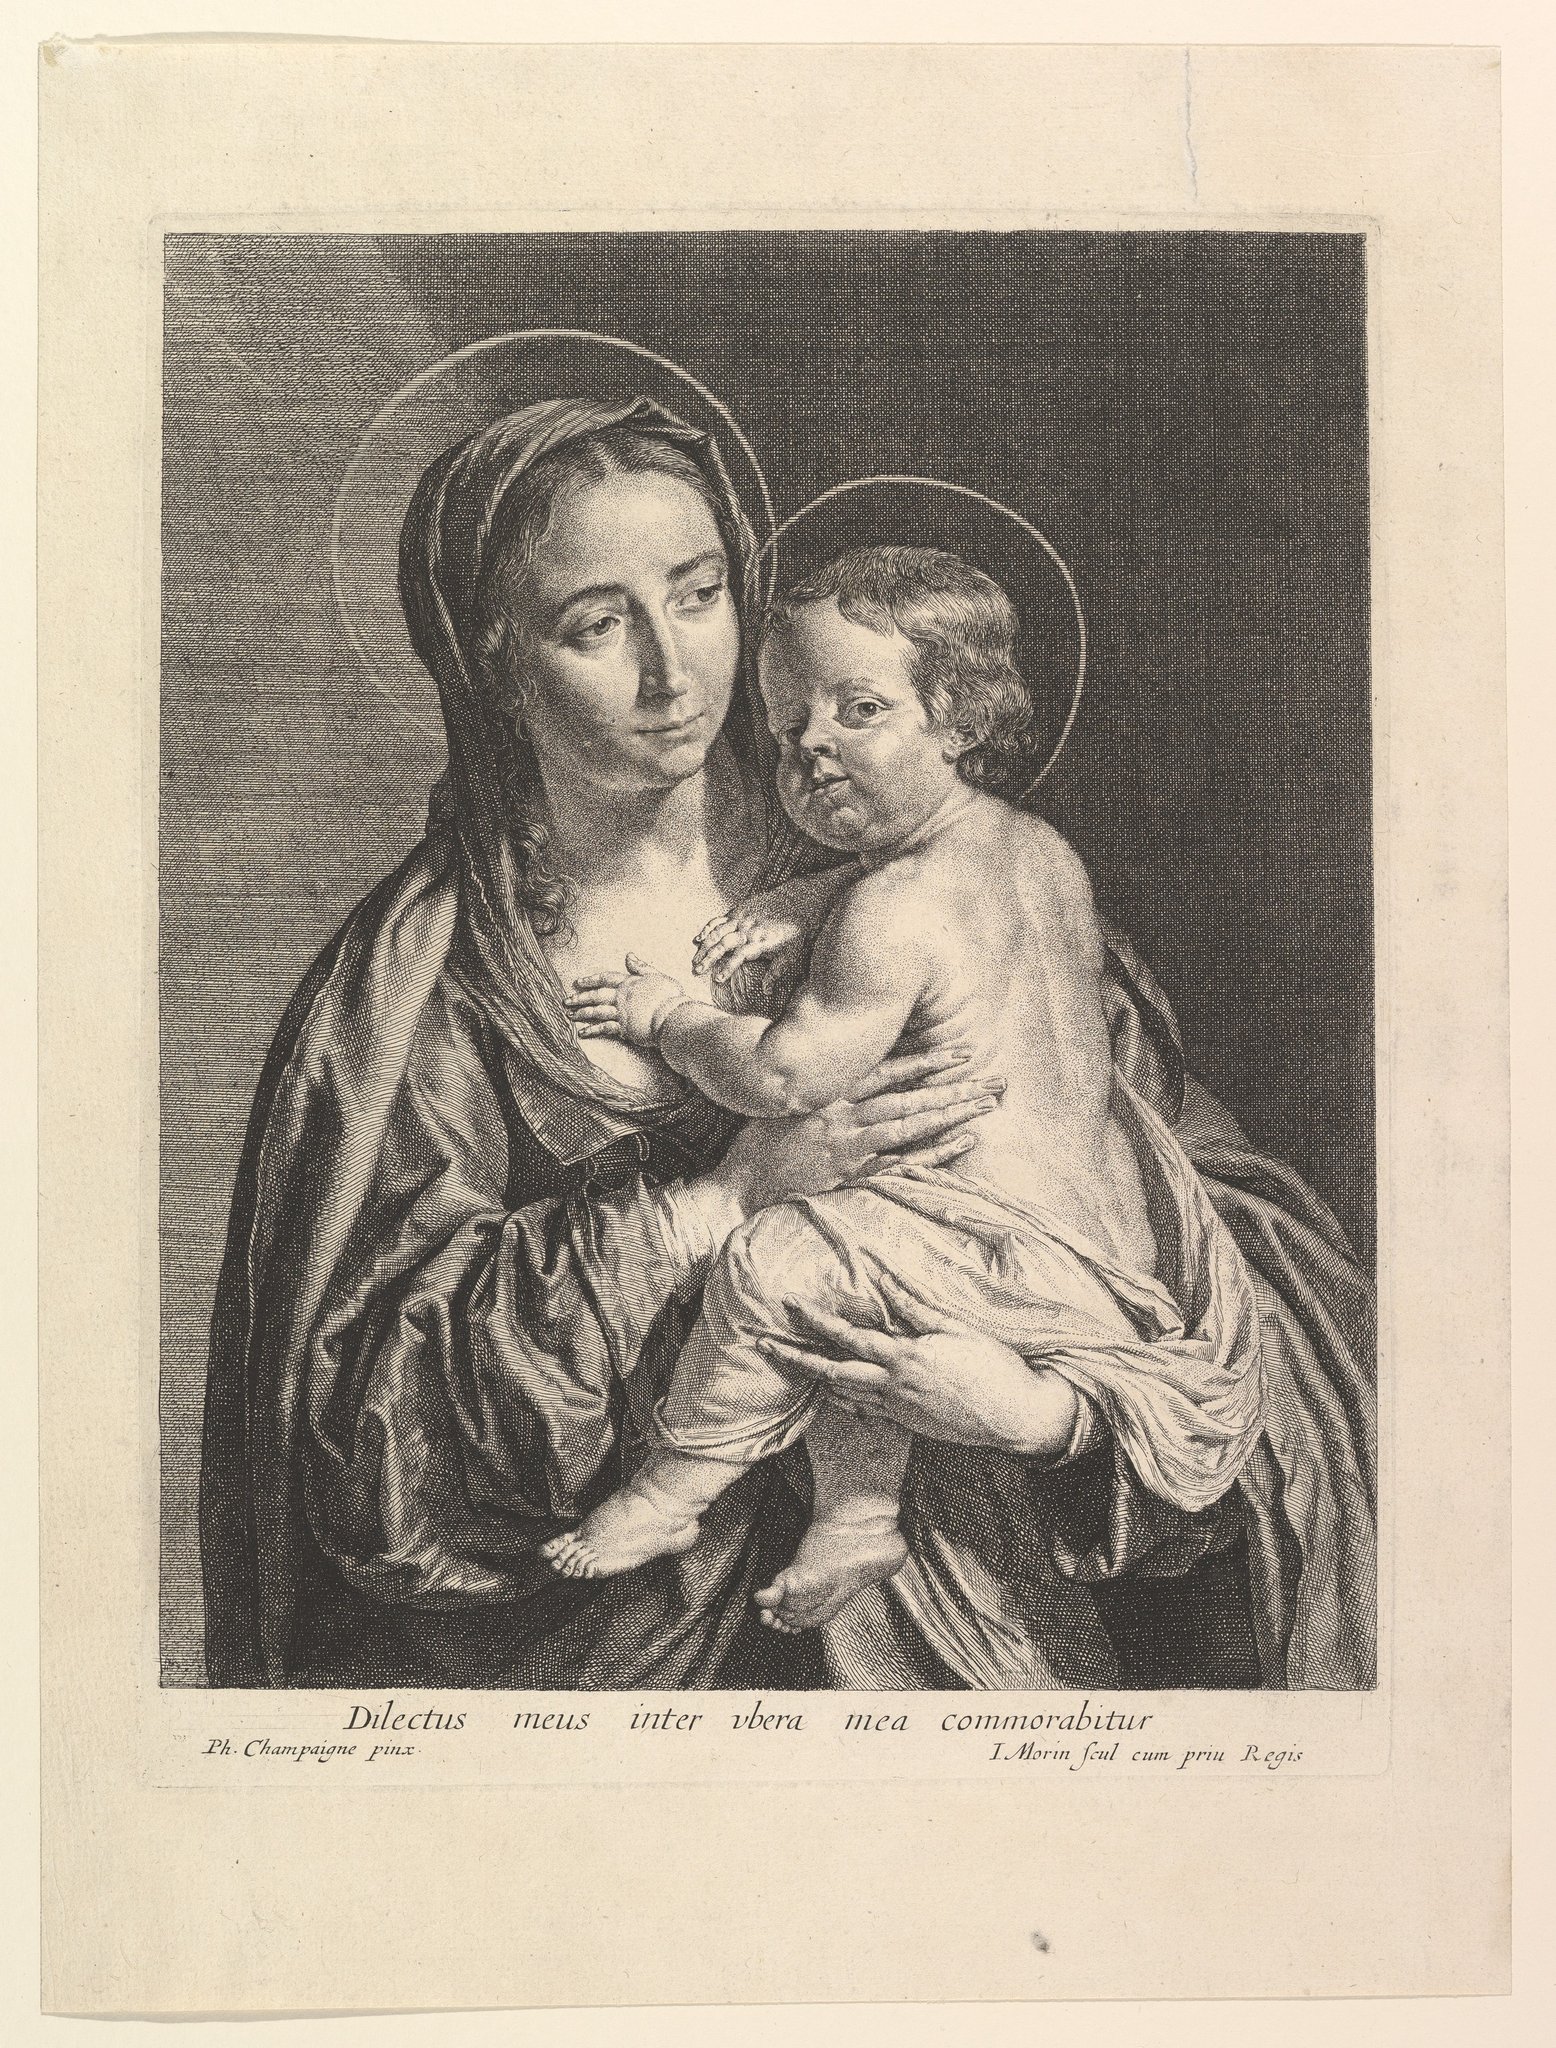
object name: print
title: La Vierge a l'enfant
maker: jean morin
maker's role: artist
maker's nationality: french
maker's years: 1605-1650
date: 1605-1650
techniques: etching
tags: madonna and child